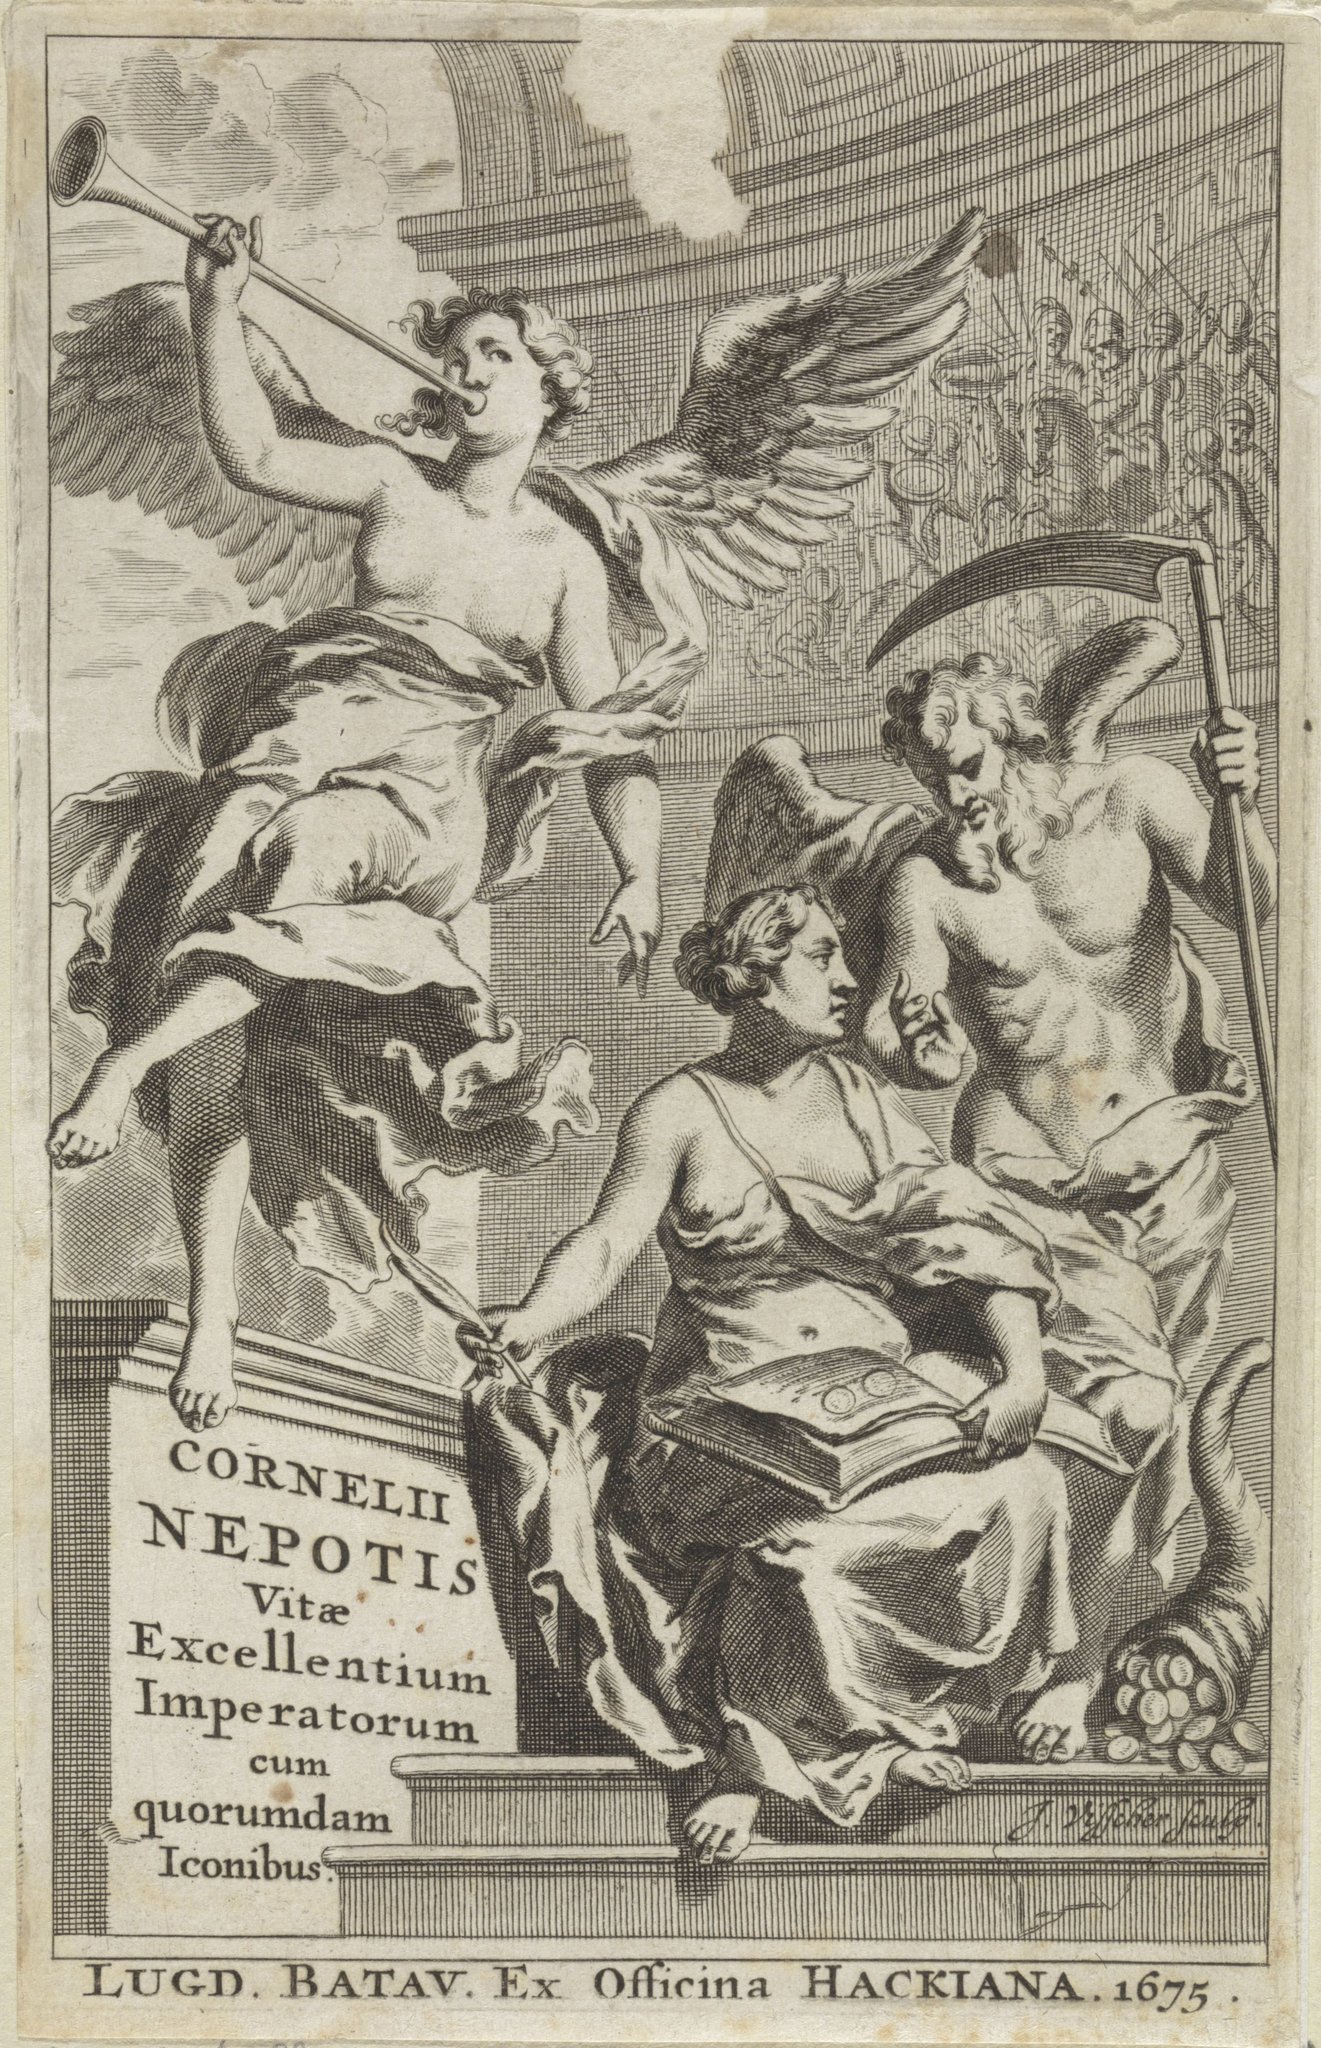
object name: print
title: Titelprent voor: Cornelius Nepos 'Vitae excellentium', 1675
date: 1675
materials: paper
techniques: engraving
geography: leiden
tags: 'historia'; 'historia' (ripa), fame; 'fama', 'fama buona', 'fama chiara' (ripa), father time, man with wings and scythe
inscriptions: collector's mark: Lugt 2228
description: Titelprent voor: Cornelius Nepos 'Vitae excellentium', 1675. Op de voorgrond een personificatie van Geschiedenis vergezeld door Vader Tijd en Faam. Aan de voeten van Vader Tijd ligt een omgekeerde hoorn des overvloeds.